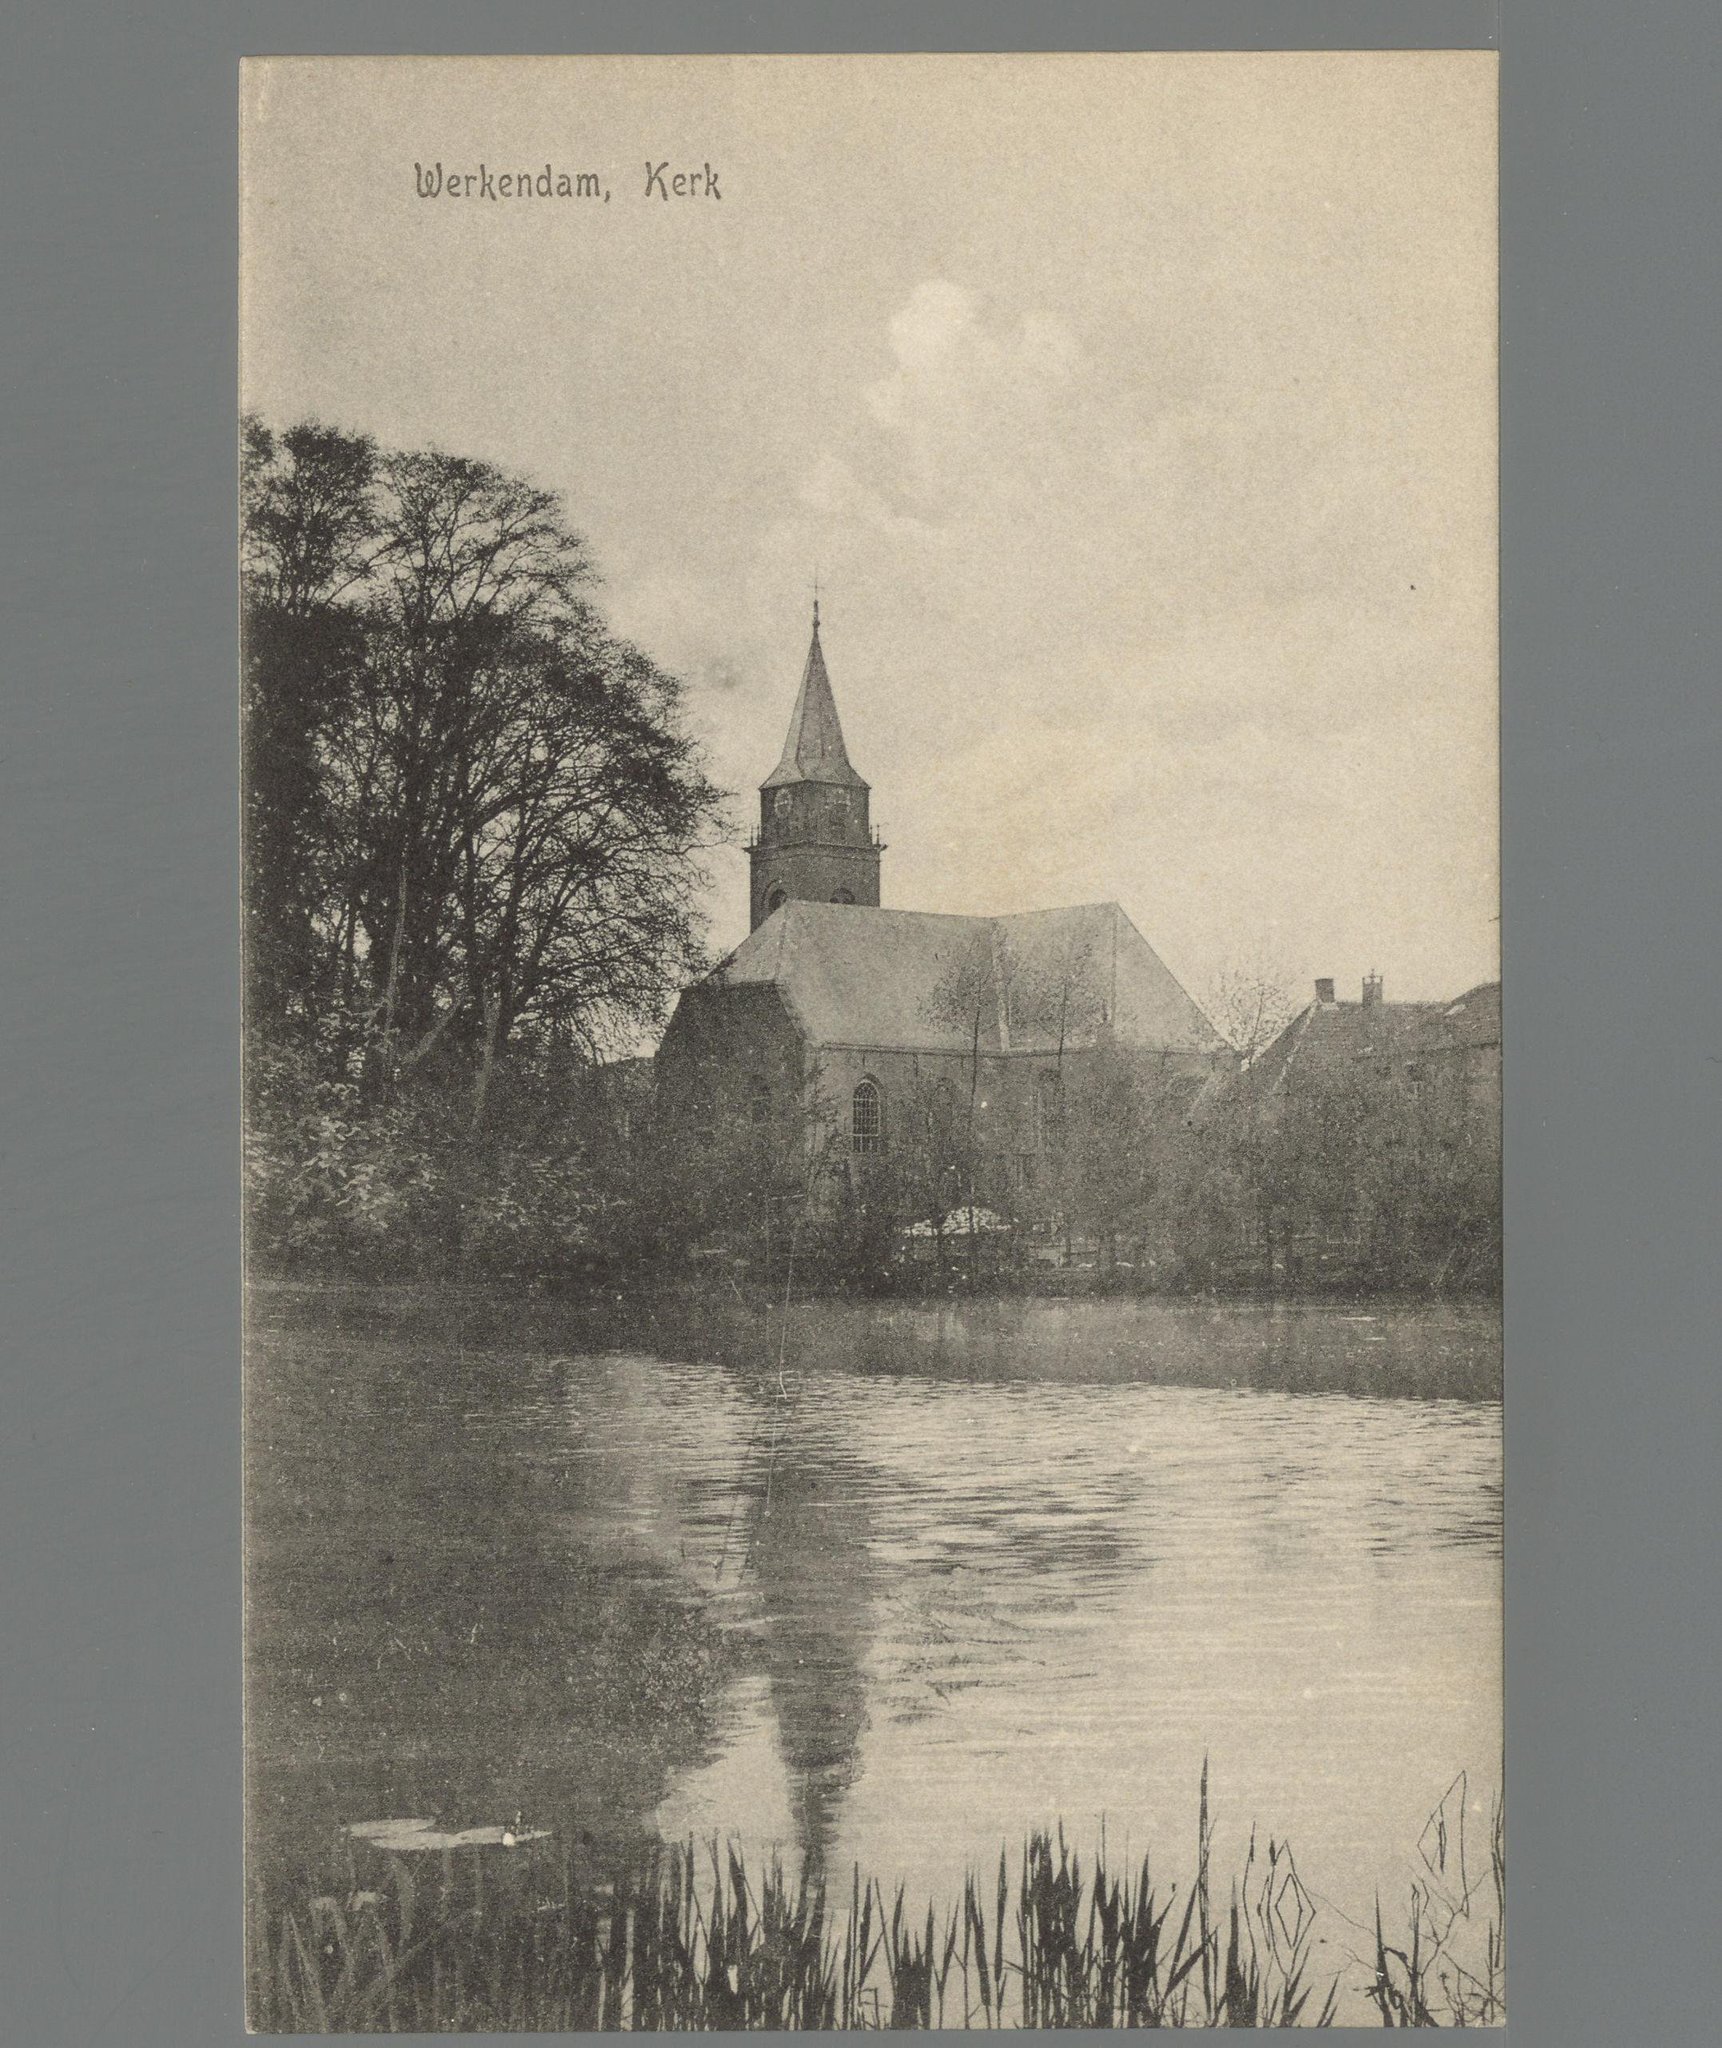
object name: ansichtkaart, prentbriefkaart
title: Werkendam, Kerk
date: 1905-1930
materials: cardboard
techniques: photograph, writing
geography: werkendam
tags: church (exterior), pond